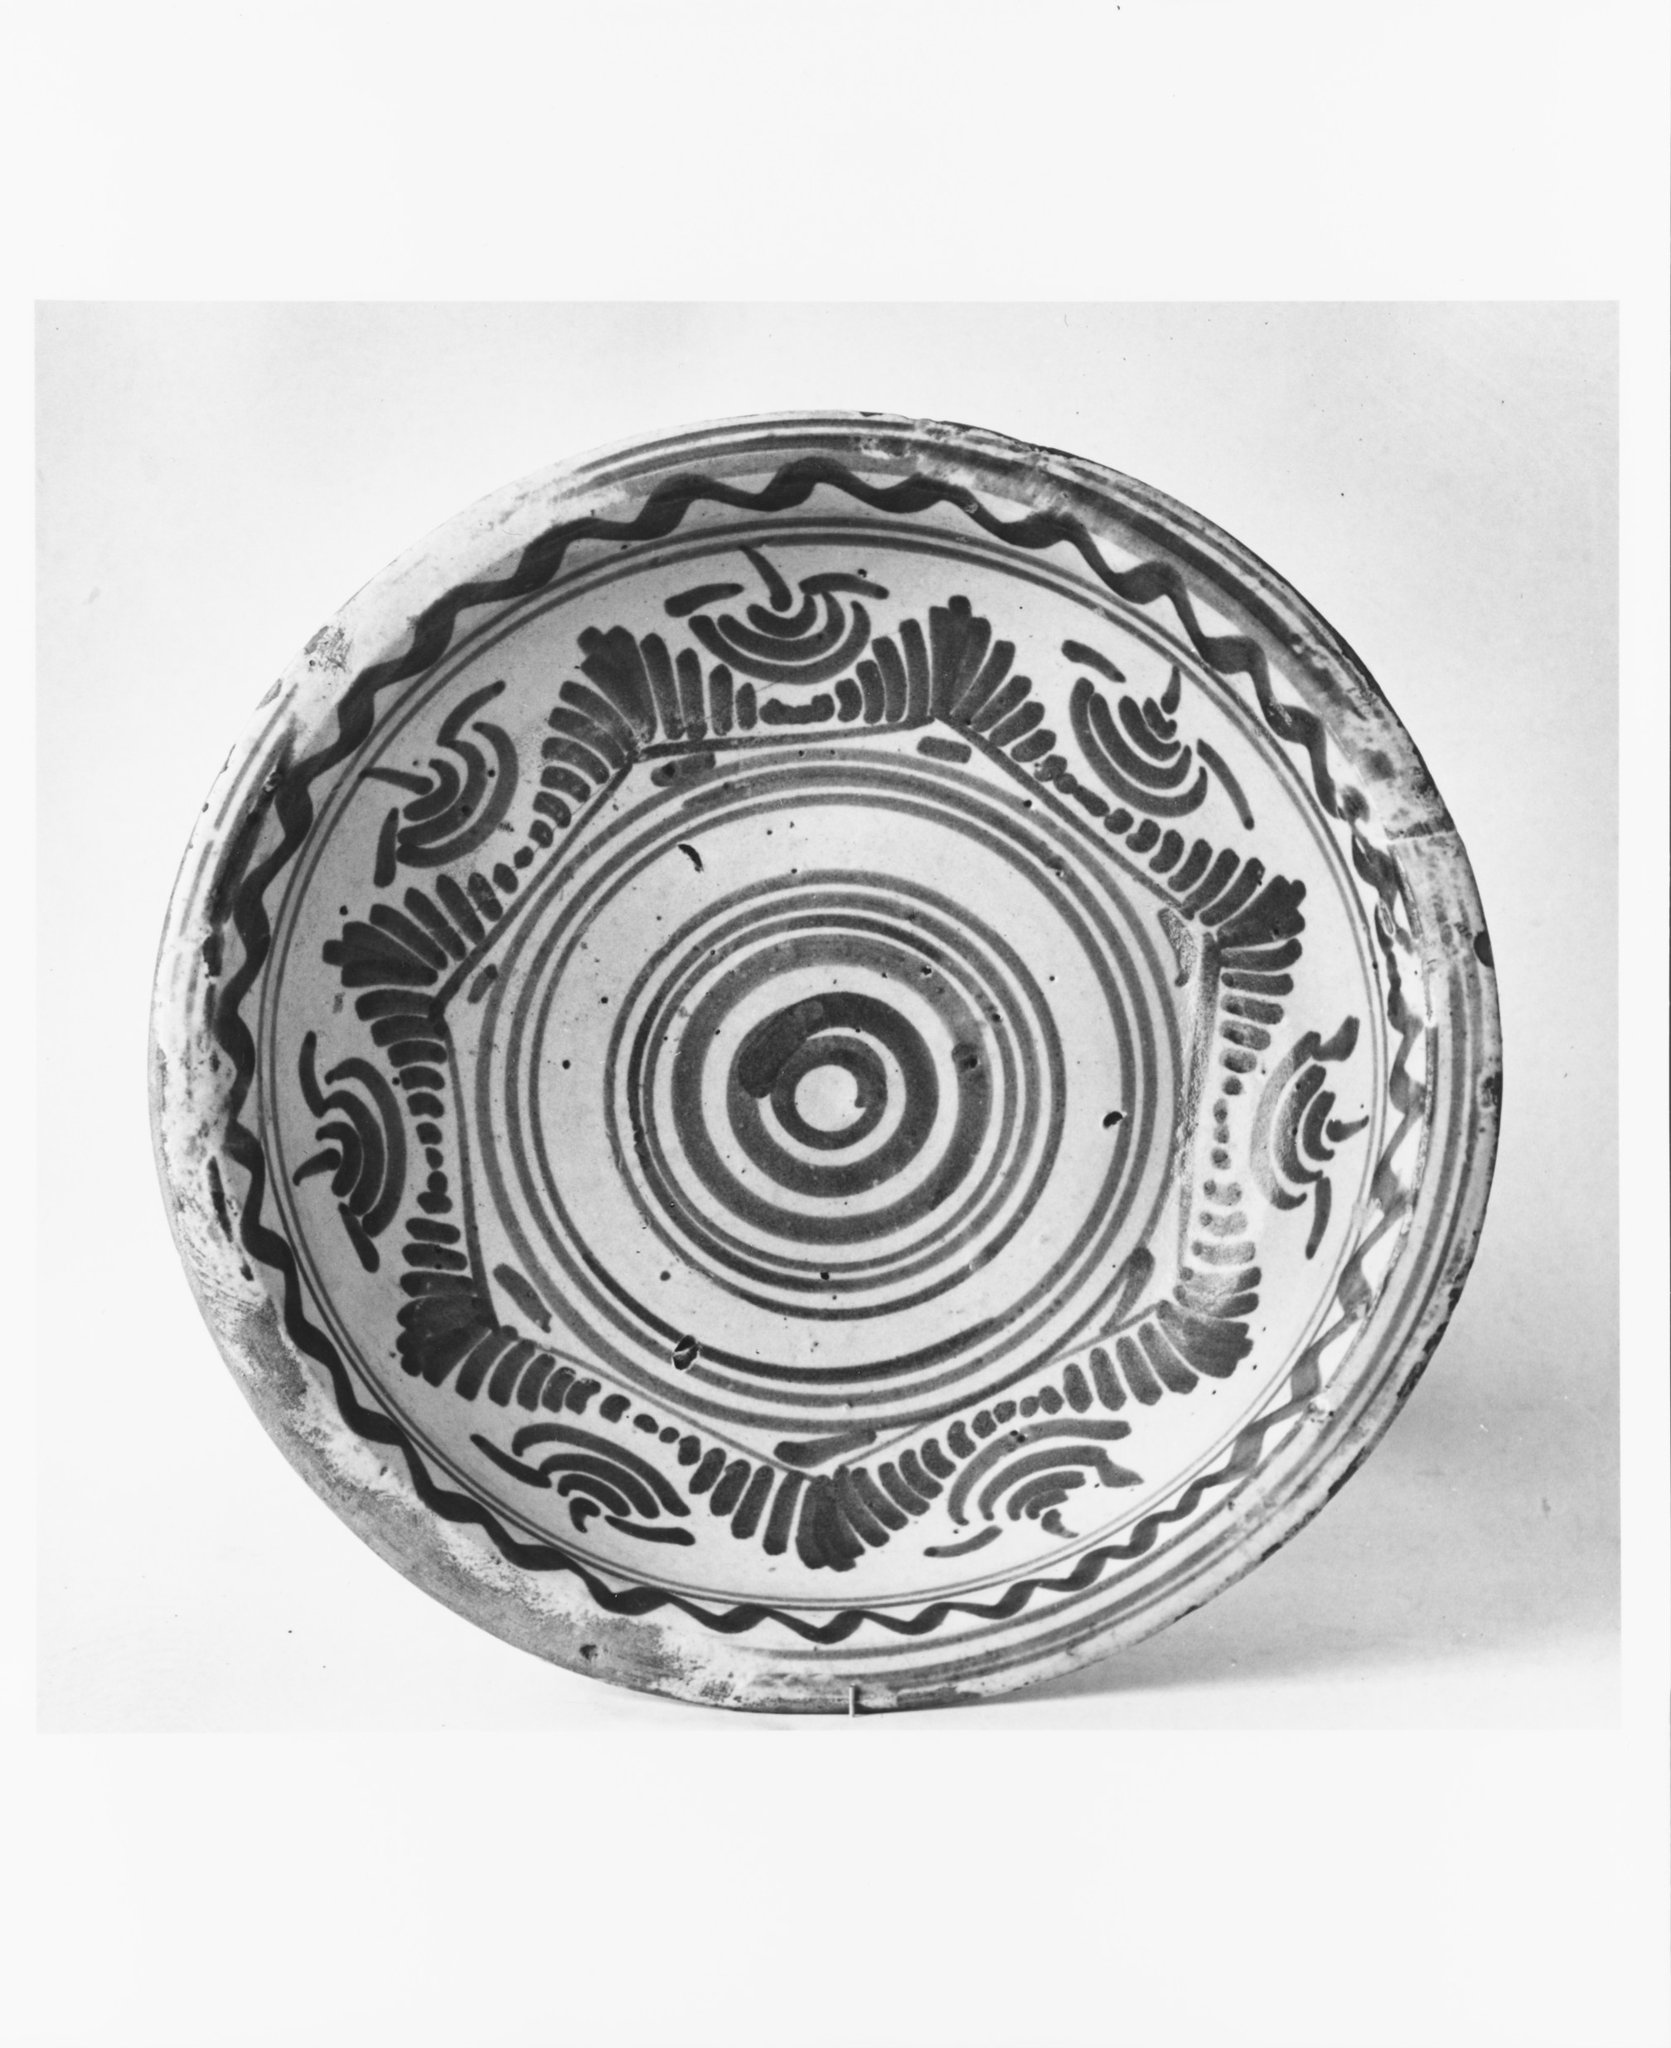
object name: bowl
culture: mexican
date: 1840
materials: earthenware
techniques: glazing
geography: mexico